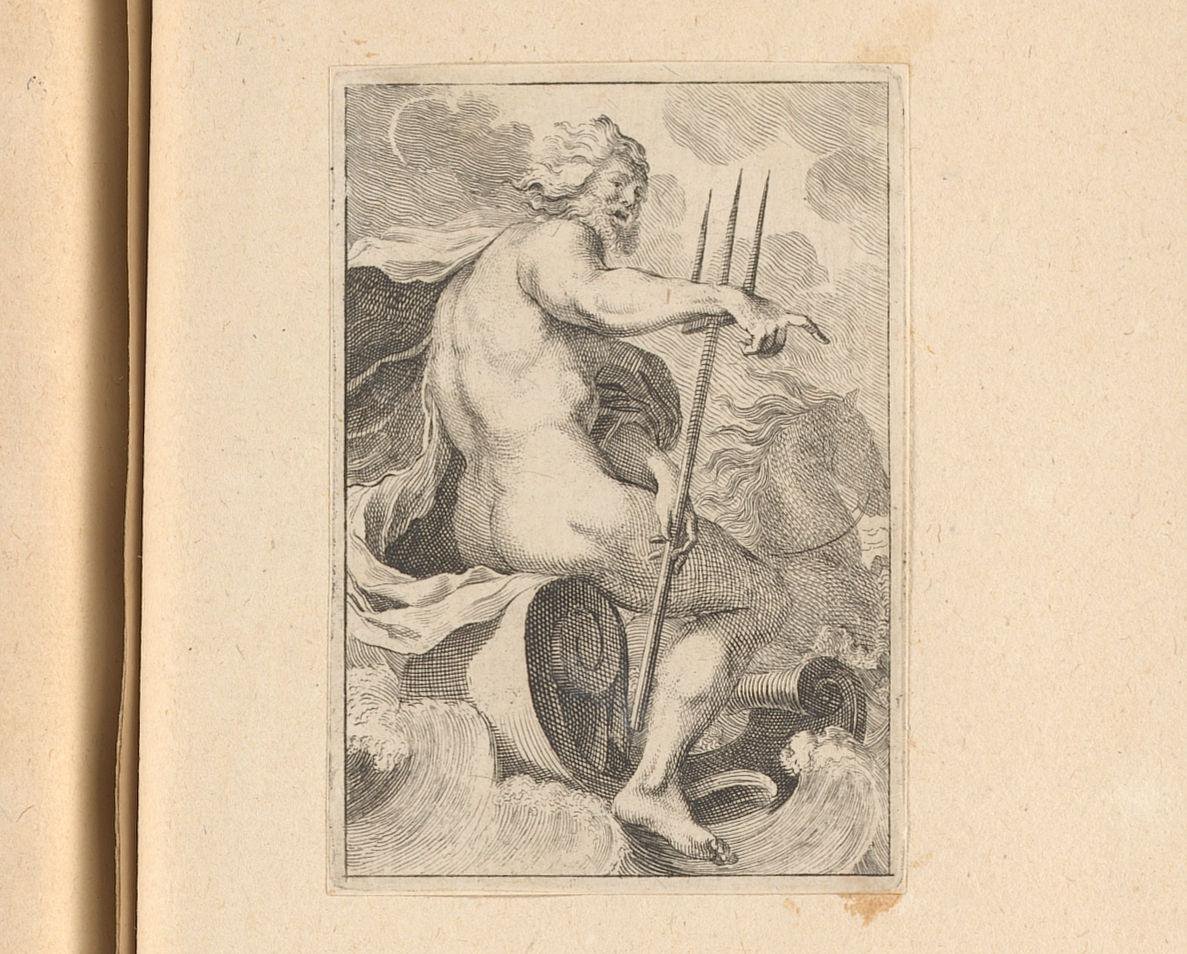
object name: album leaf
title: Tekenvoorbeelden van goden en helden uit de klassieke oudheid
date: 1665-1673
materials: paper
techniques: etching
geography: paris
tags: (story of) neptune (poseidon), model-books ~ implements of painter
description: Prent uit een 32-delige serie met tekenvoorbeelden van goden en helden uit de klassieke oudheid. Een eerste editie werd in 1673 uitgegeven en een tweede in 1684 door Nicolas Langlois.